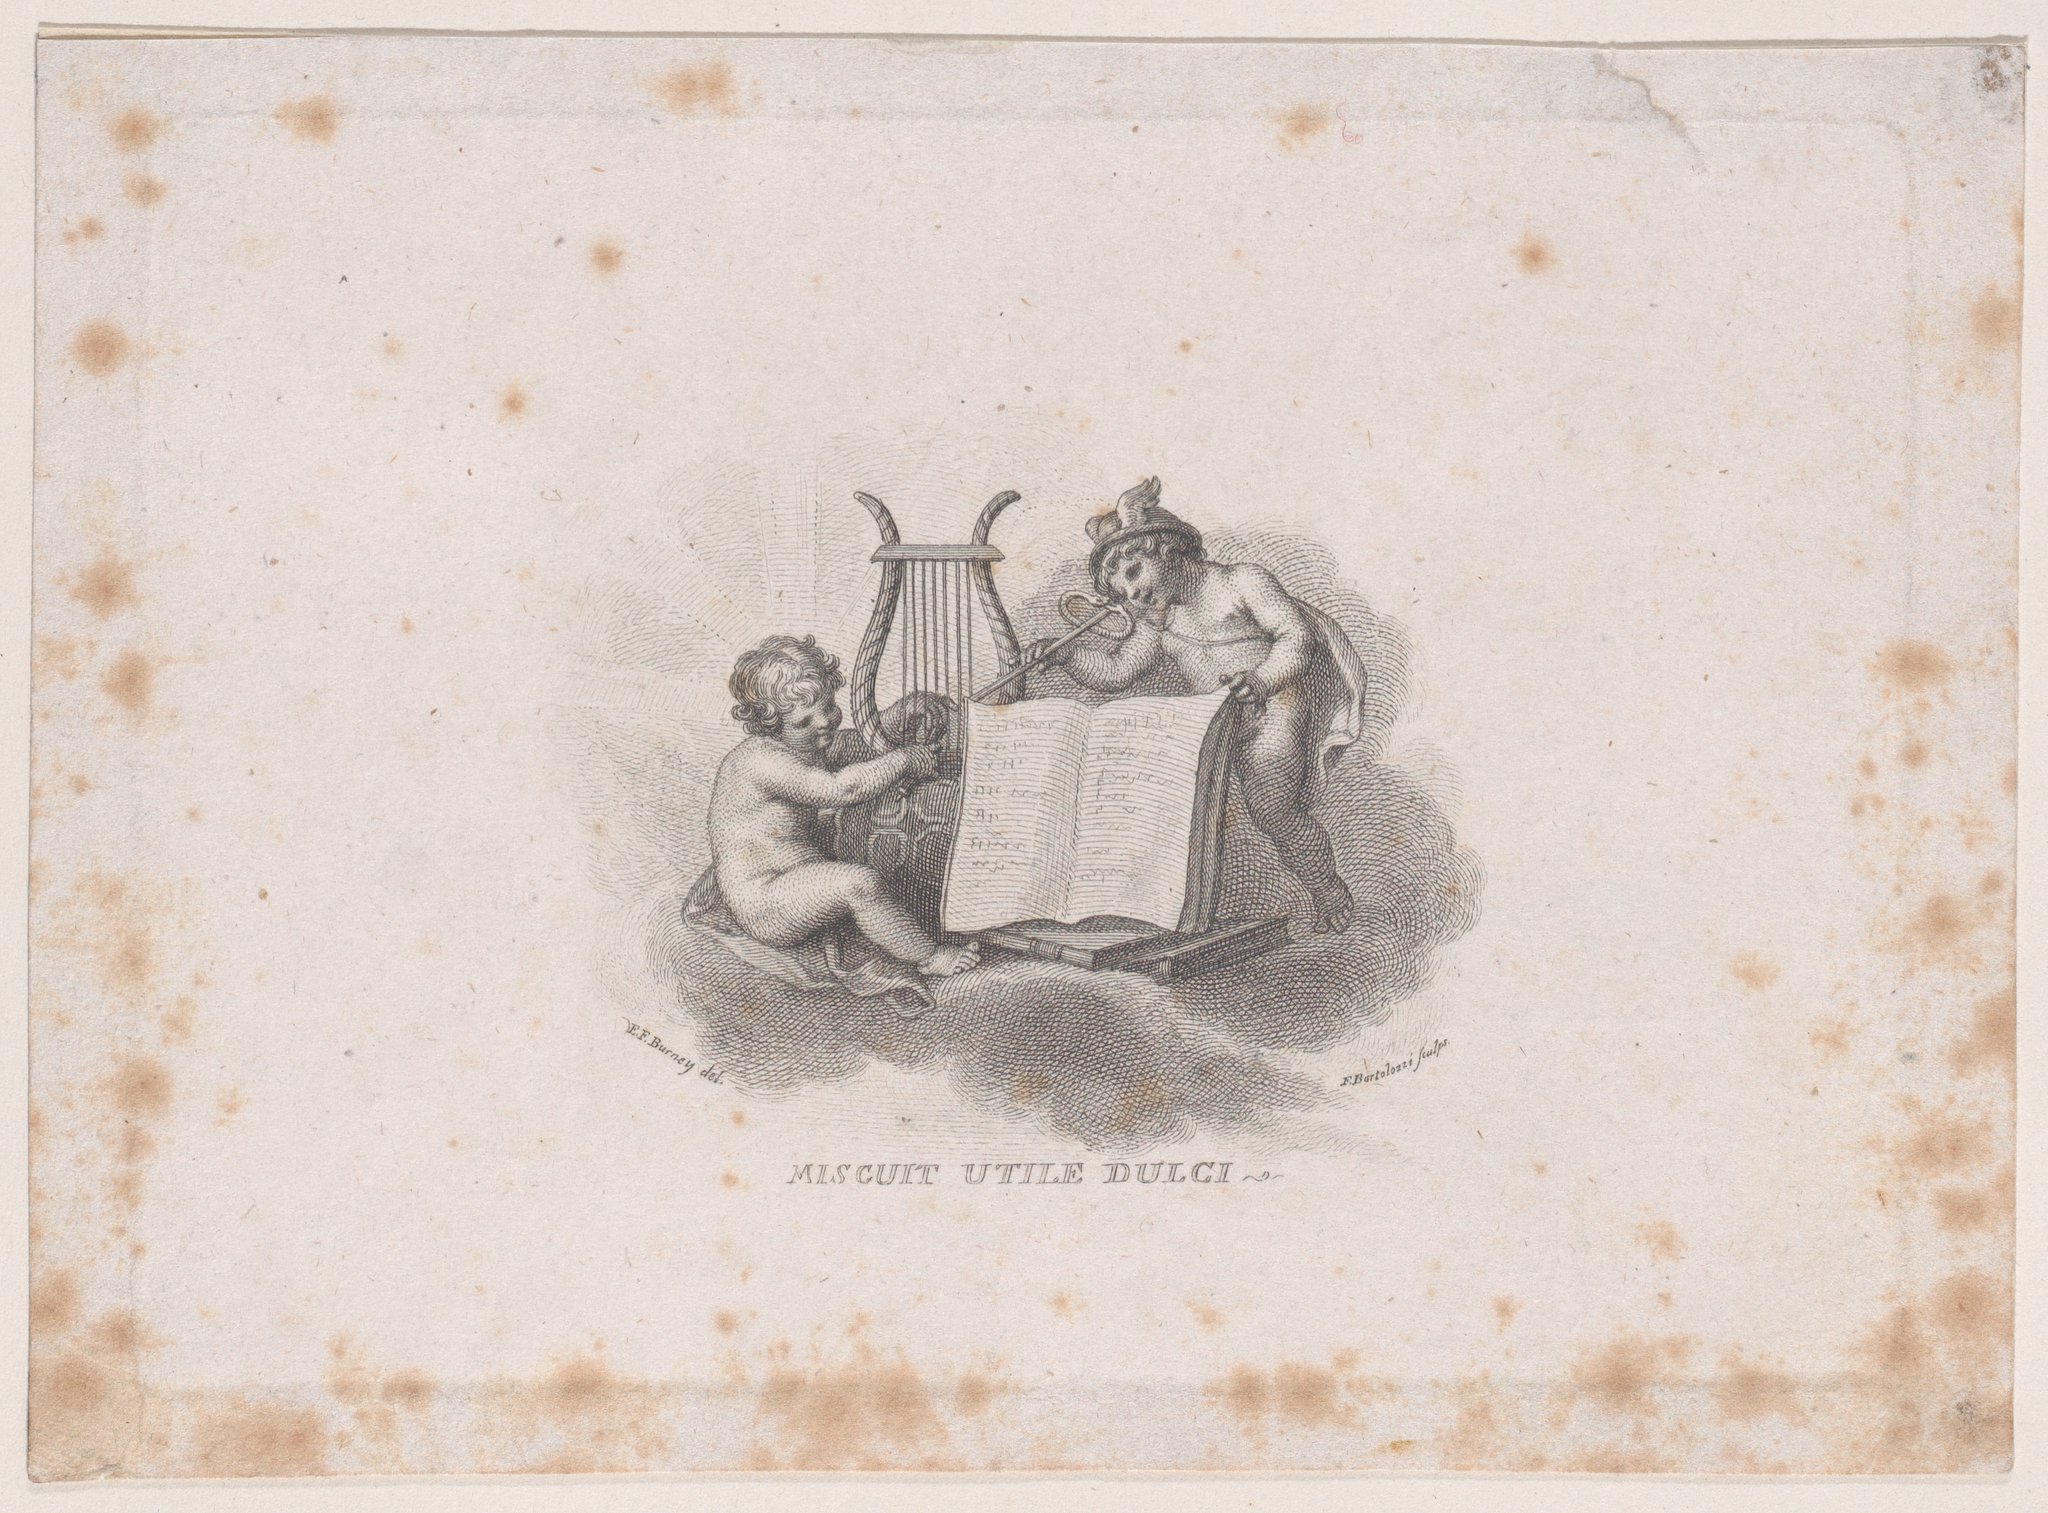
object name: print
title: Apollo and Mercury as Infants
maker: francesco bartolozzi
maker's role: artist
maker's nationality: italian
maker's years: 1728-1815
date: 1797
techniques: etching, engraving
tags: infants,apollo,mercury